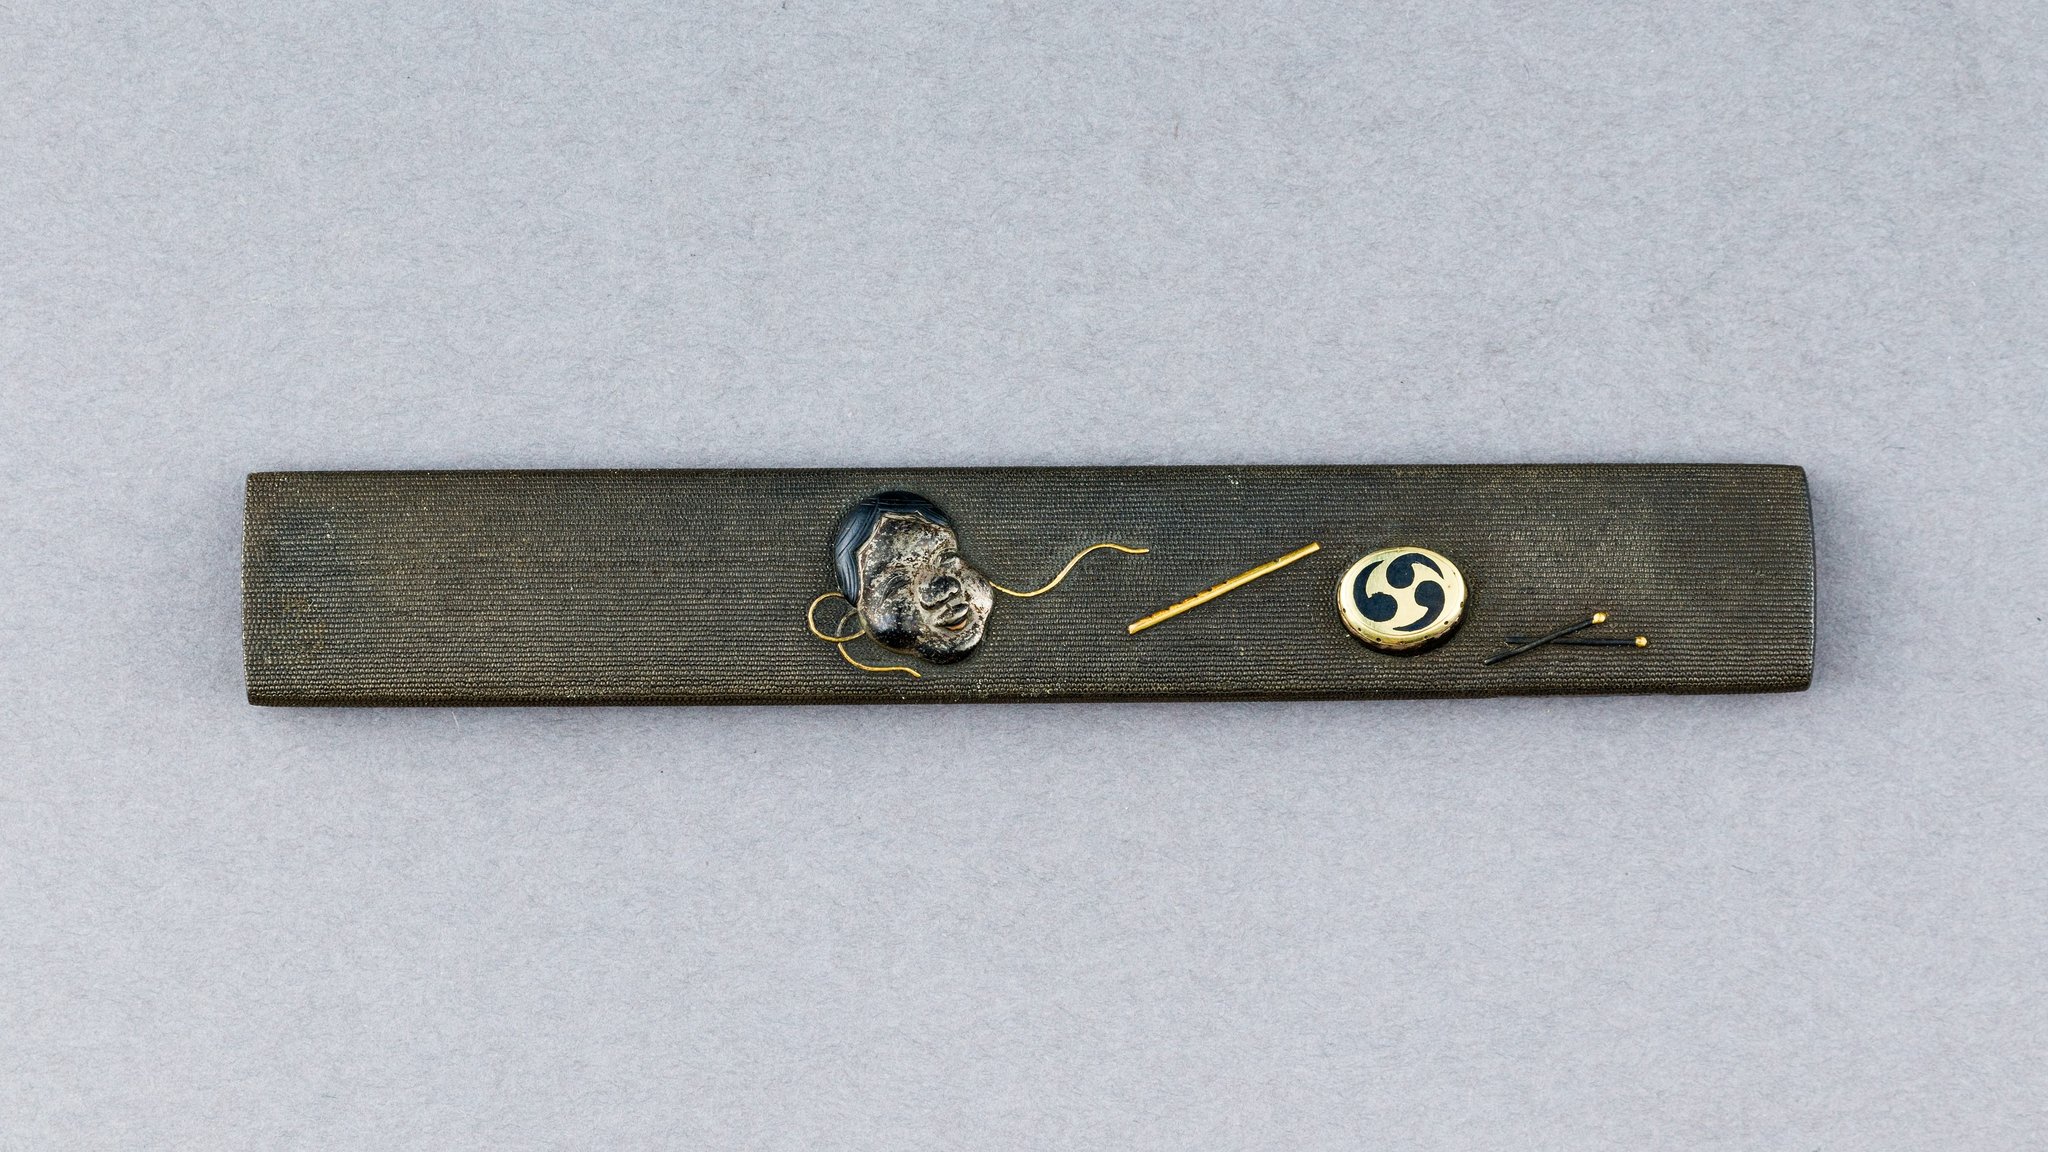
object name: knife handle kozuka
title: Knife Handle (Kozuka)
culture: japanese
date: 1615-1868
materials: gold alloy, silver alloy, gold, silver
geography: japan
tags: masks